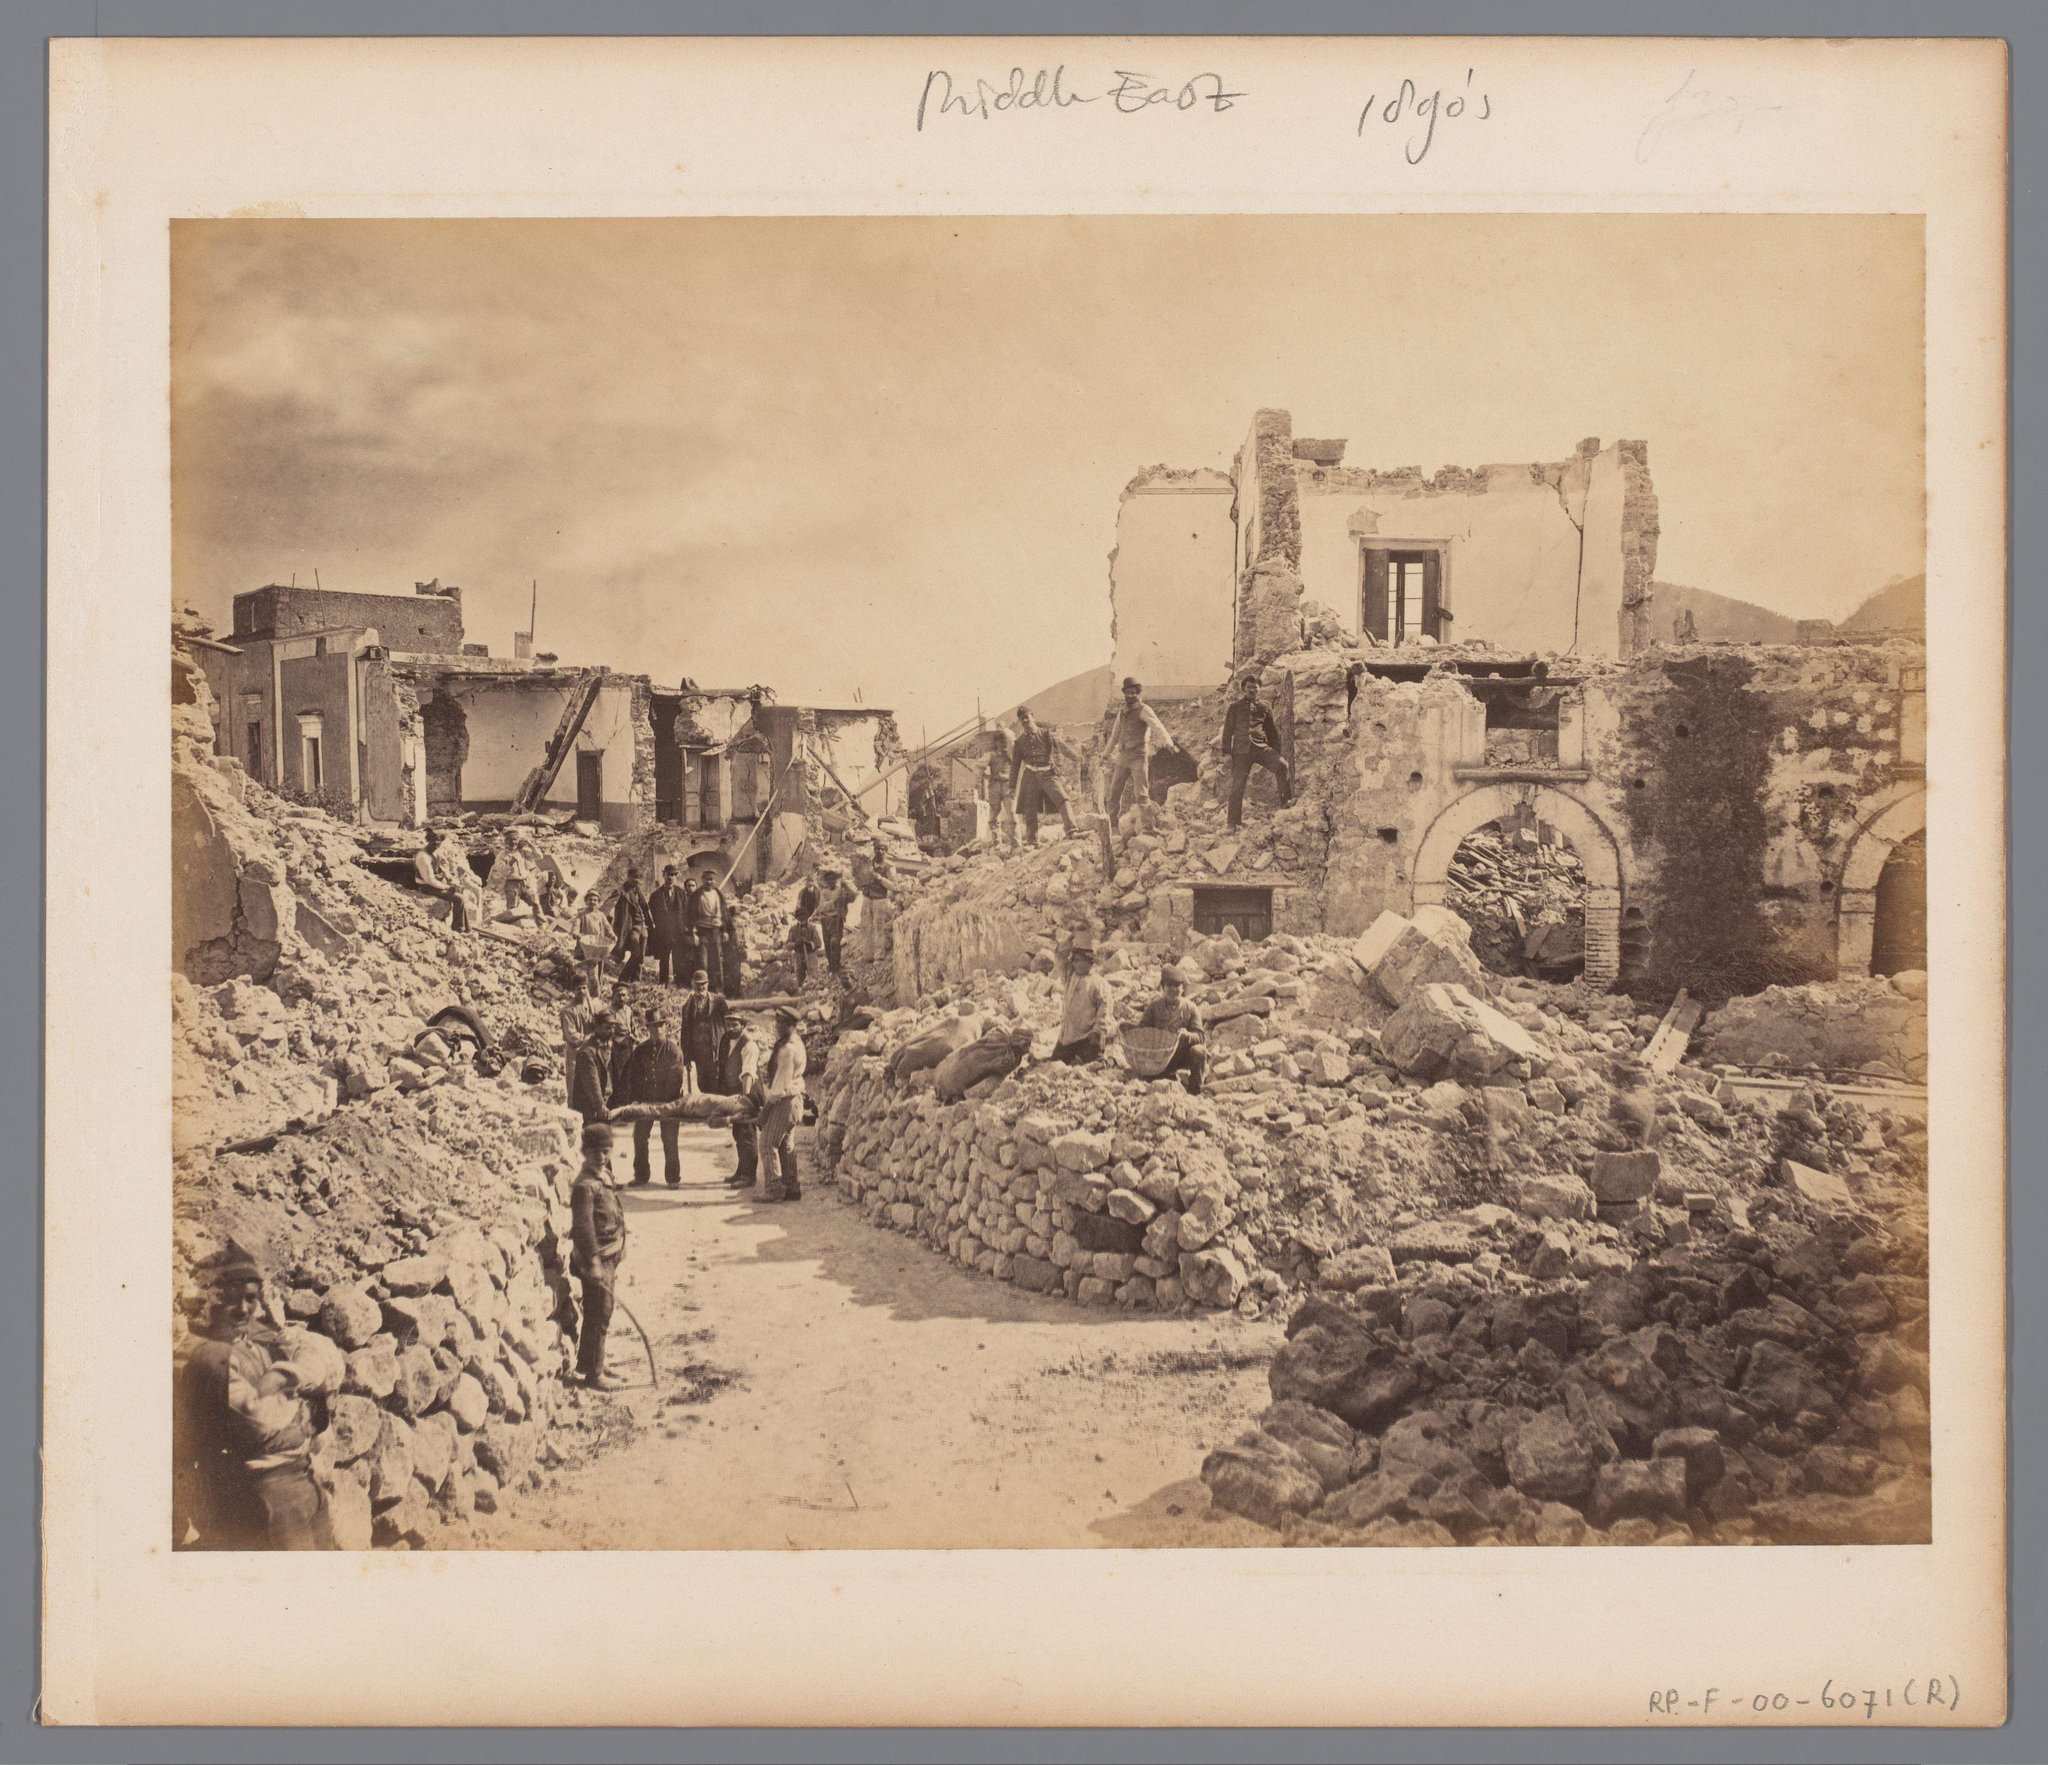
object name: photograph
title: Verwoesting door een aardbeving in Zuid-Italië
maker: Anonymous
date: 1905-1908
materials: cardboard, paper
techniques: albumen print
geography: italy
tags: (carrying a person on a) litter, stretcher, consequences of an earthquake, ruin of a dwelling, house, castle, etc., calabria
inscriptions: inscription: ‘Middle East 1890's’, annotation: ‘f 30,-’